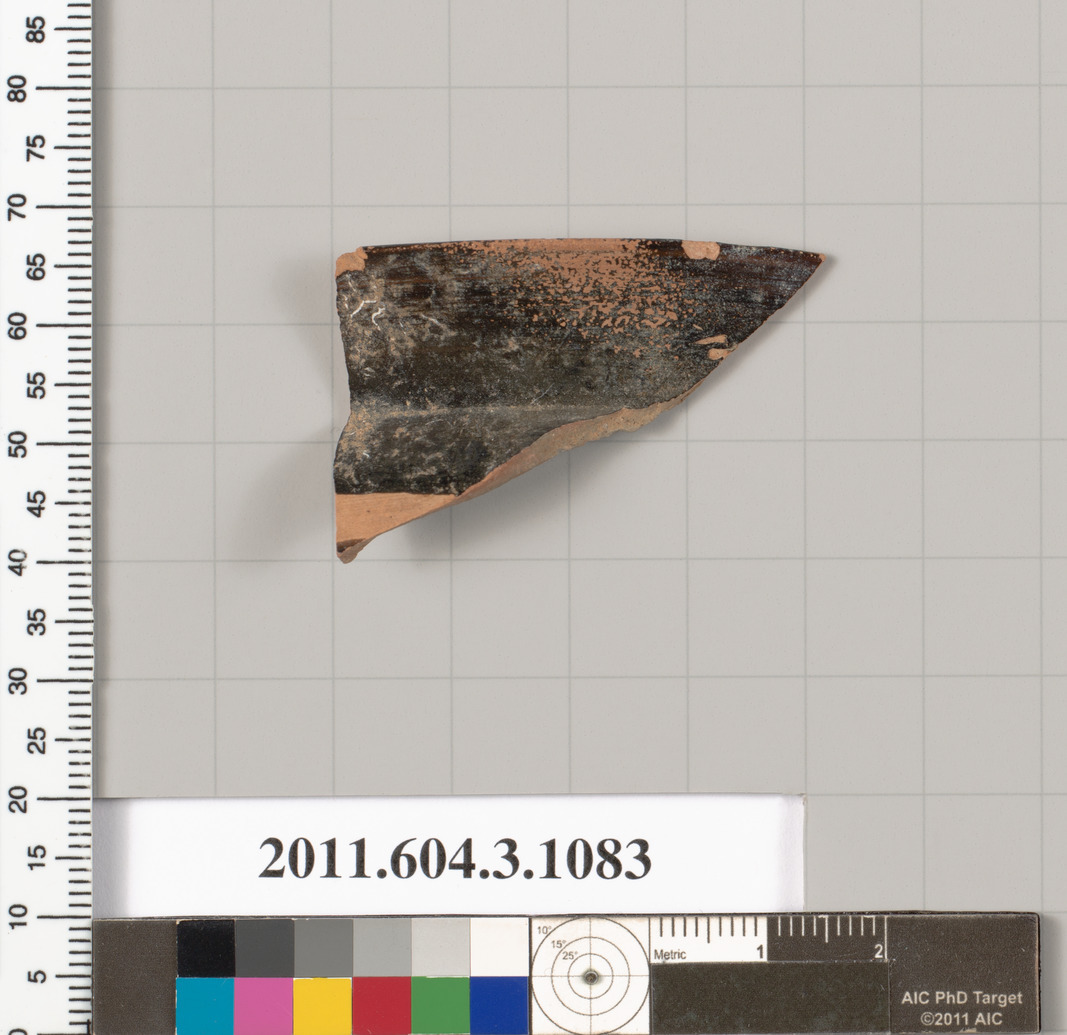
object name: mastoid fragment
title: Terracotta rim fragment of a mastoid (drinking cup with narrow base)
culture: greek, attic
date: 534-468 BCE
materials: terracotta